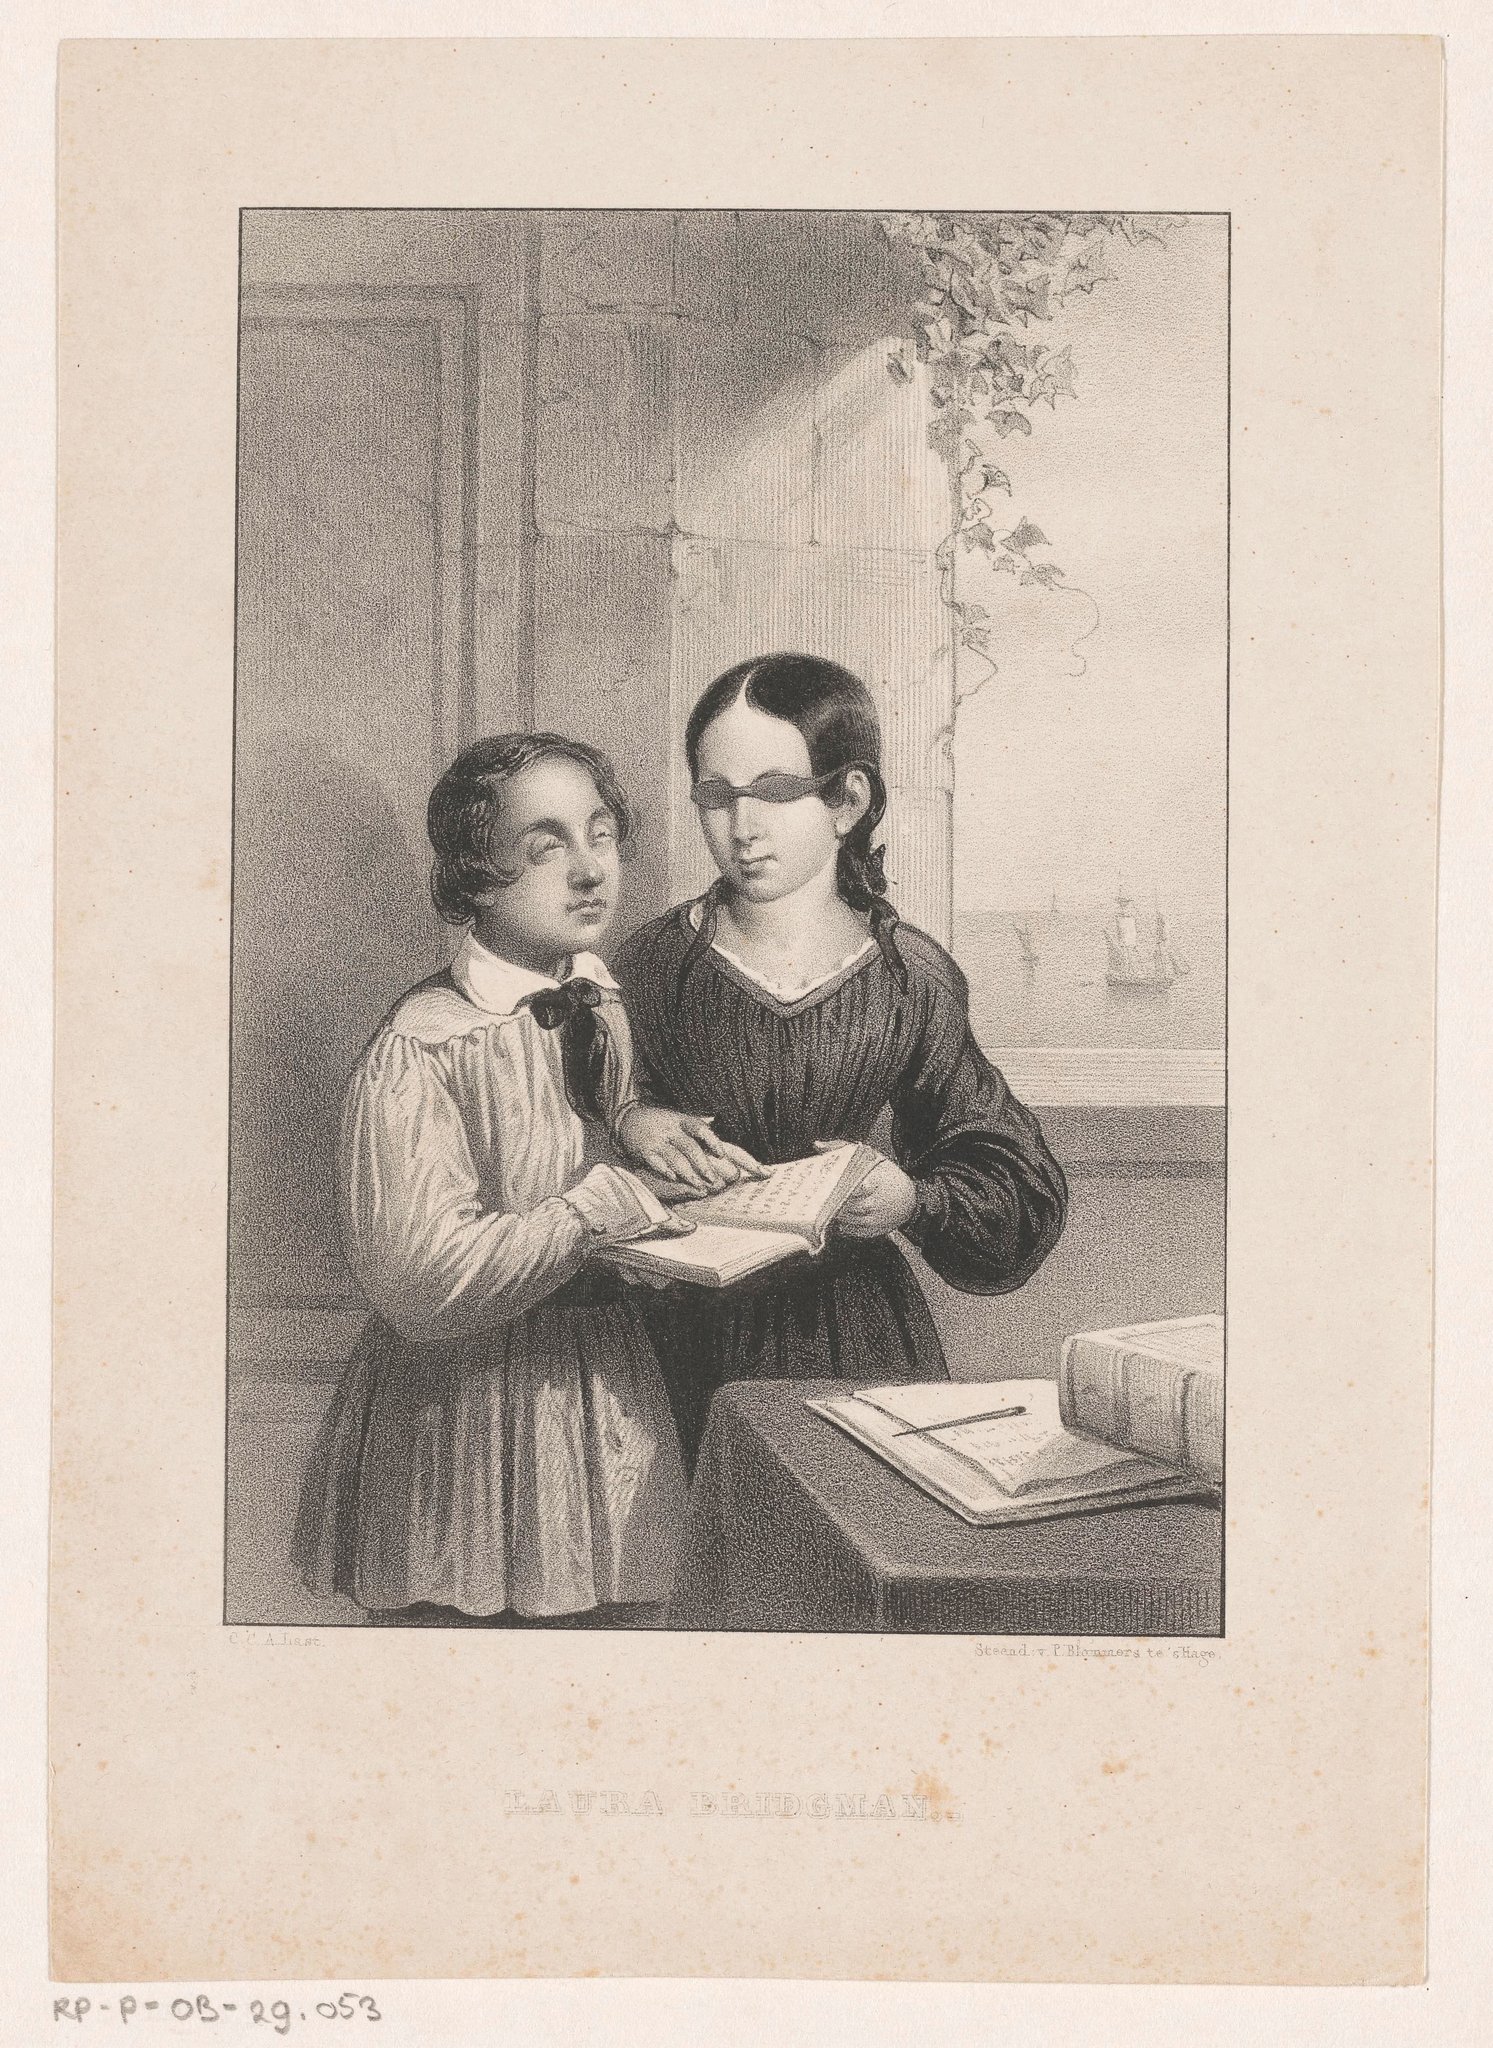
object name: print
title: Laura Bridgman leert Oliver Caswell lezen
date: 1844-1887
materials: paper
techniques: lithograph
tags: reading, blind, blindness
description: De twee blinden staan bij een tafel. Laura Bridgman houdt de hand van Oliver Caswell vast en begeleidt deze over het papier met braille.